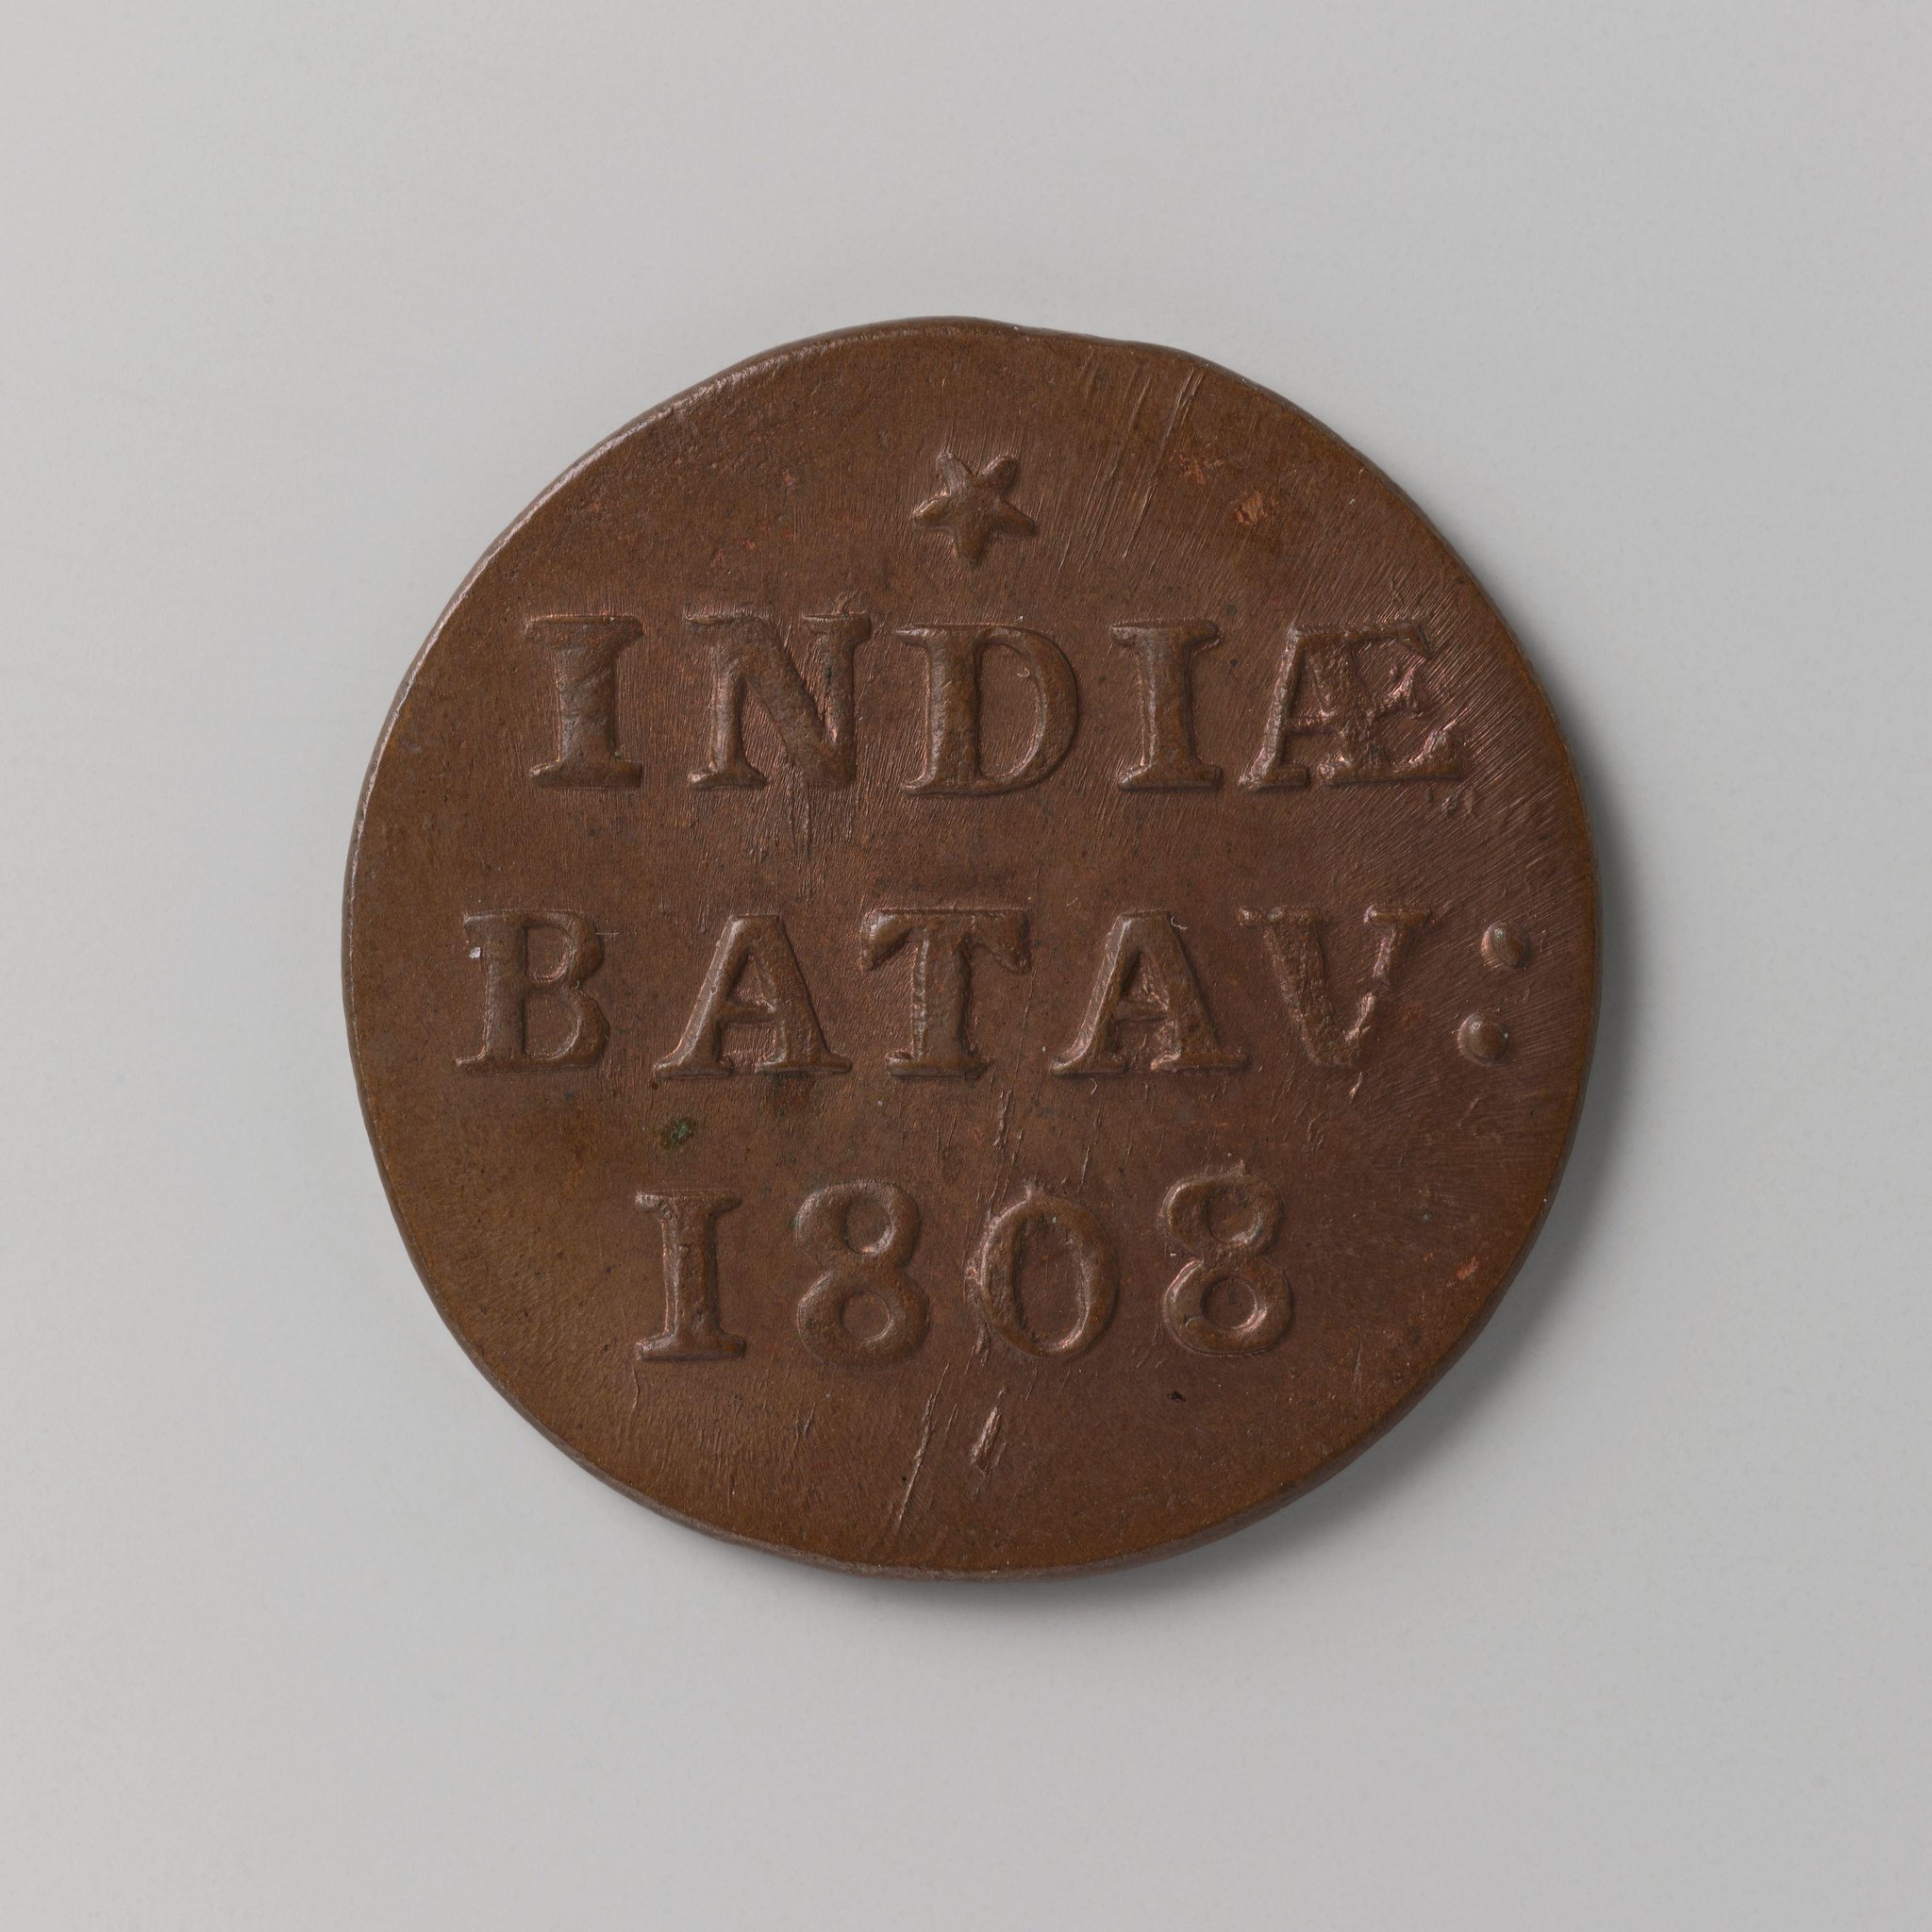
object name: coin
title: Nederlands Indië, duit Holland,1808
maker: louis napoleon (king of holland)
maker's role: koning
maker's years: 1778-1846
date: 1808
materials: copper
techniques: striking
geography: hoorn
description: Koperen munt. Voorzijde: tweeregelig opschrift, waarboven muntteken ster en waaronder jaartal. Keerzijde: tussen waarde-aanduiding 5 1/16 G gekroond generaliteitswapenschild. Gladde rand.